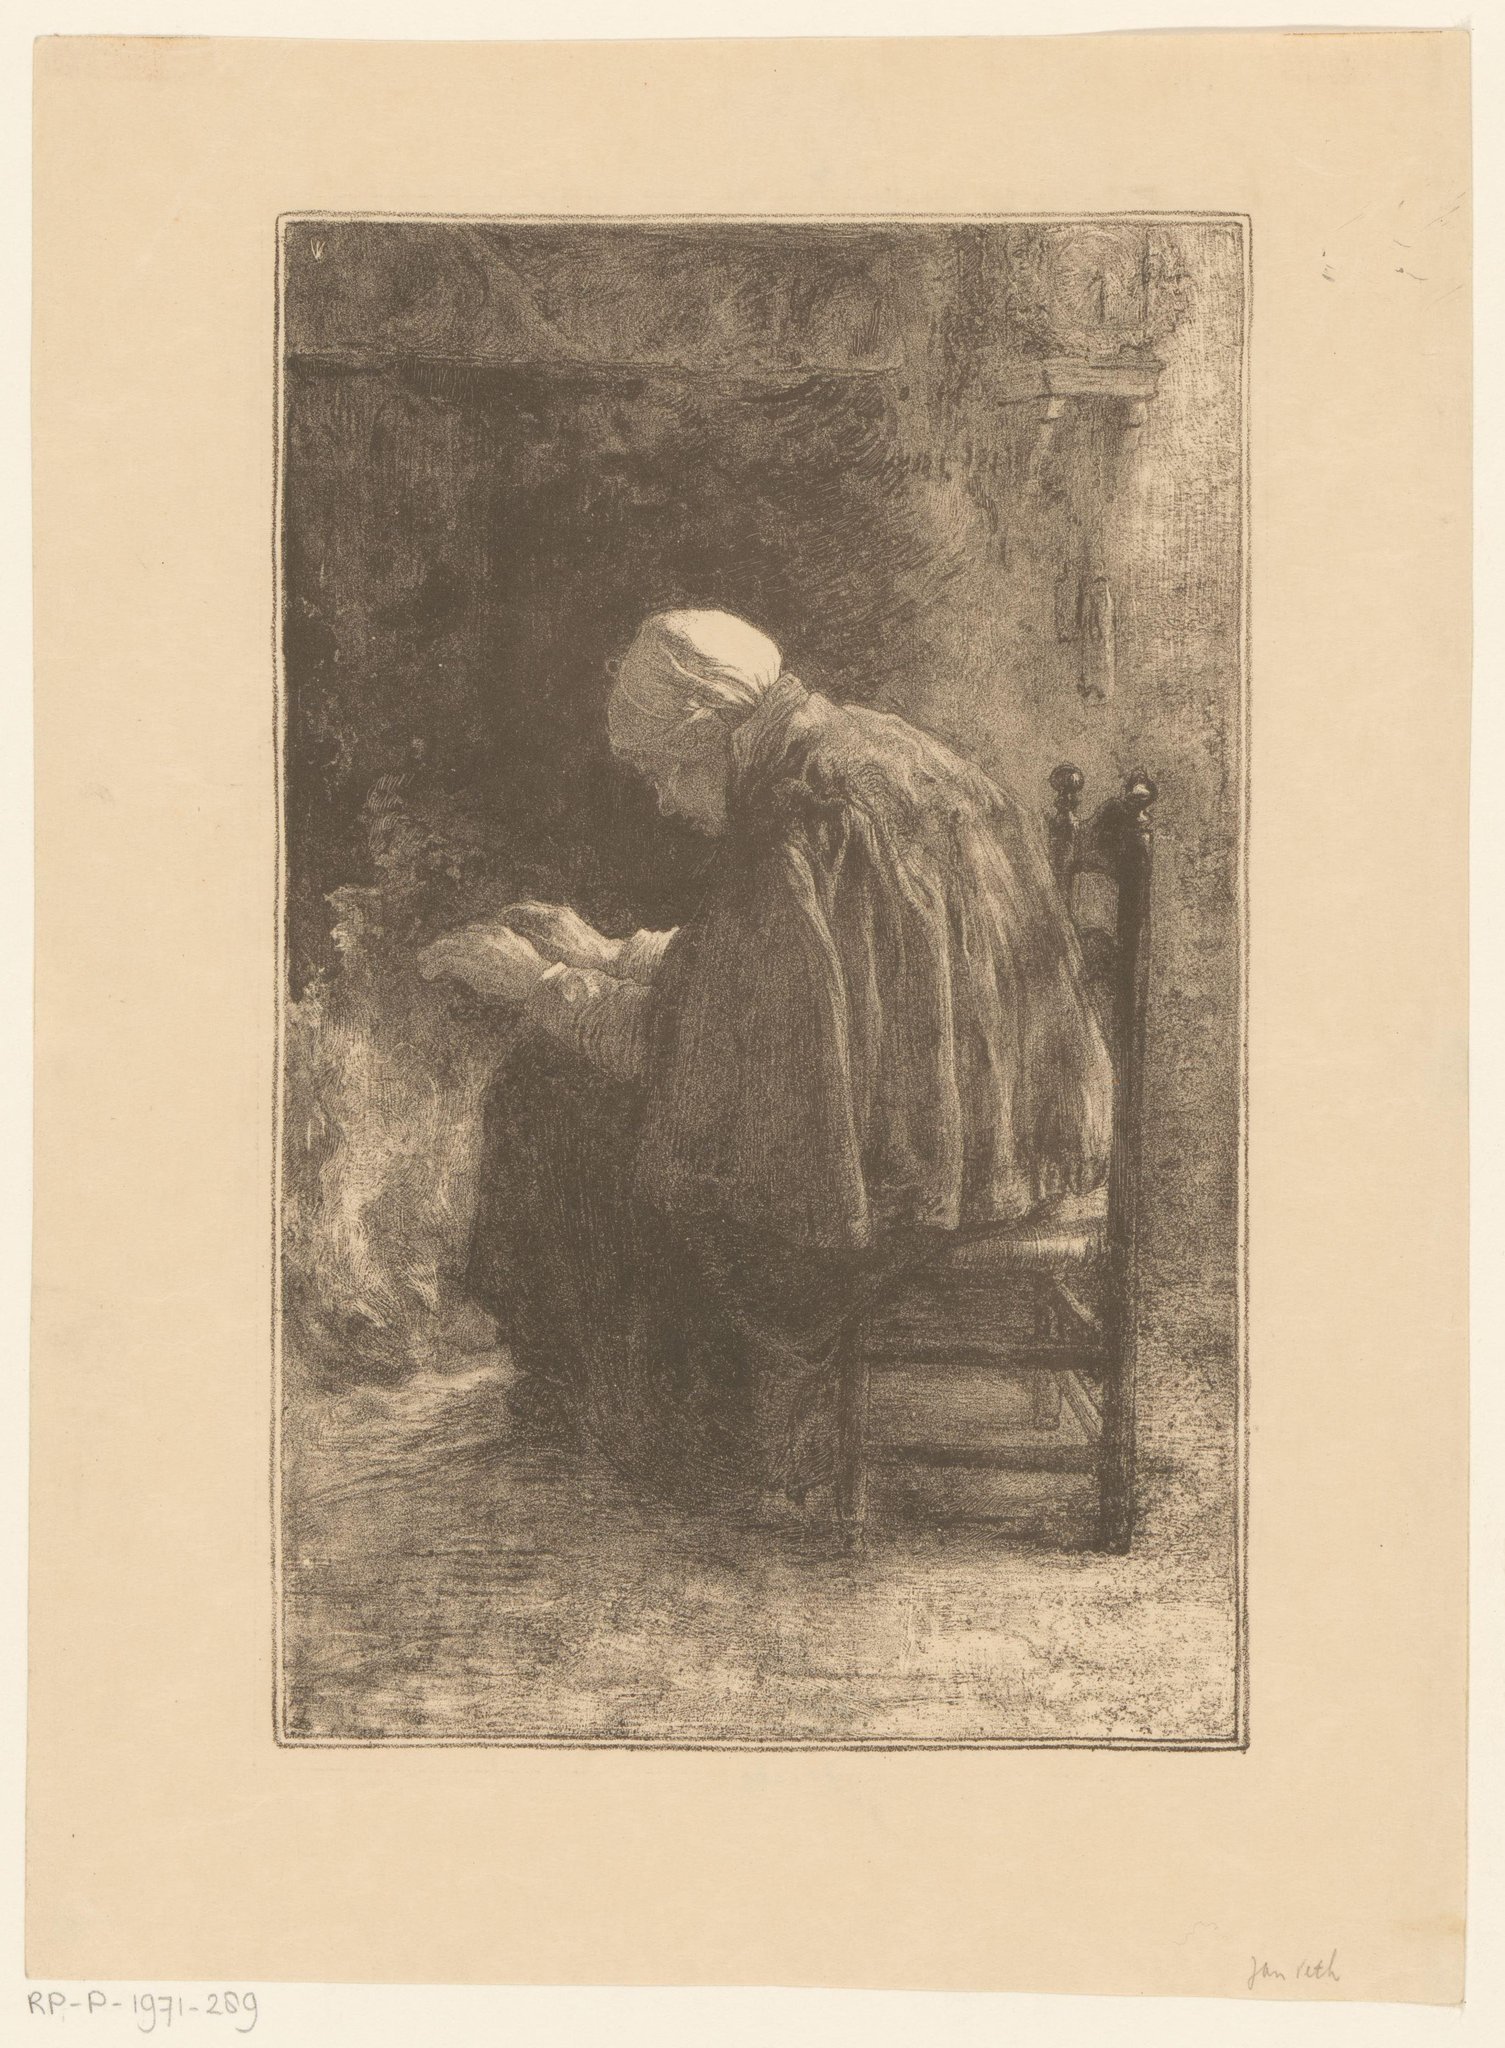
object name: print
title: We Grow Old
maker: jan veth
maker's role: designer, draughtsman, painter, print maker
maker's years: 1864-1925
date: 1883-1893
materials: paper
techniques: lithograph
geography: netherlands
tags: warming oneself at a fire (or hearth, stove, fire-pan, brazier)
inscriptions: collector's mark: Lugt 2228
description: Oude vrouw, zittend op stoel, haar handen warmend aan de haard. Rechts naast haar een krukje met kom erop. Links aan de muur hangt een wandklok.